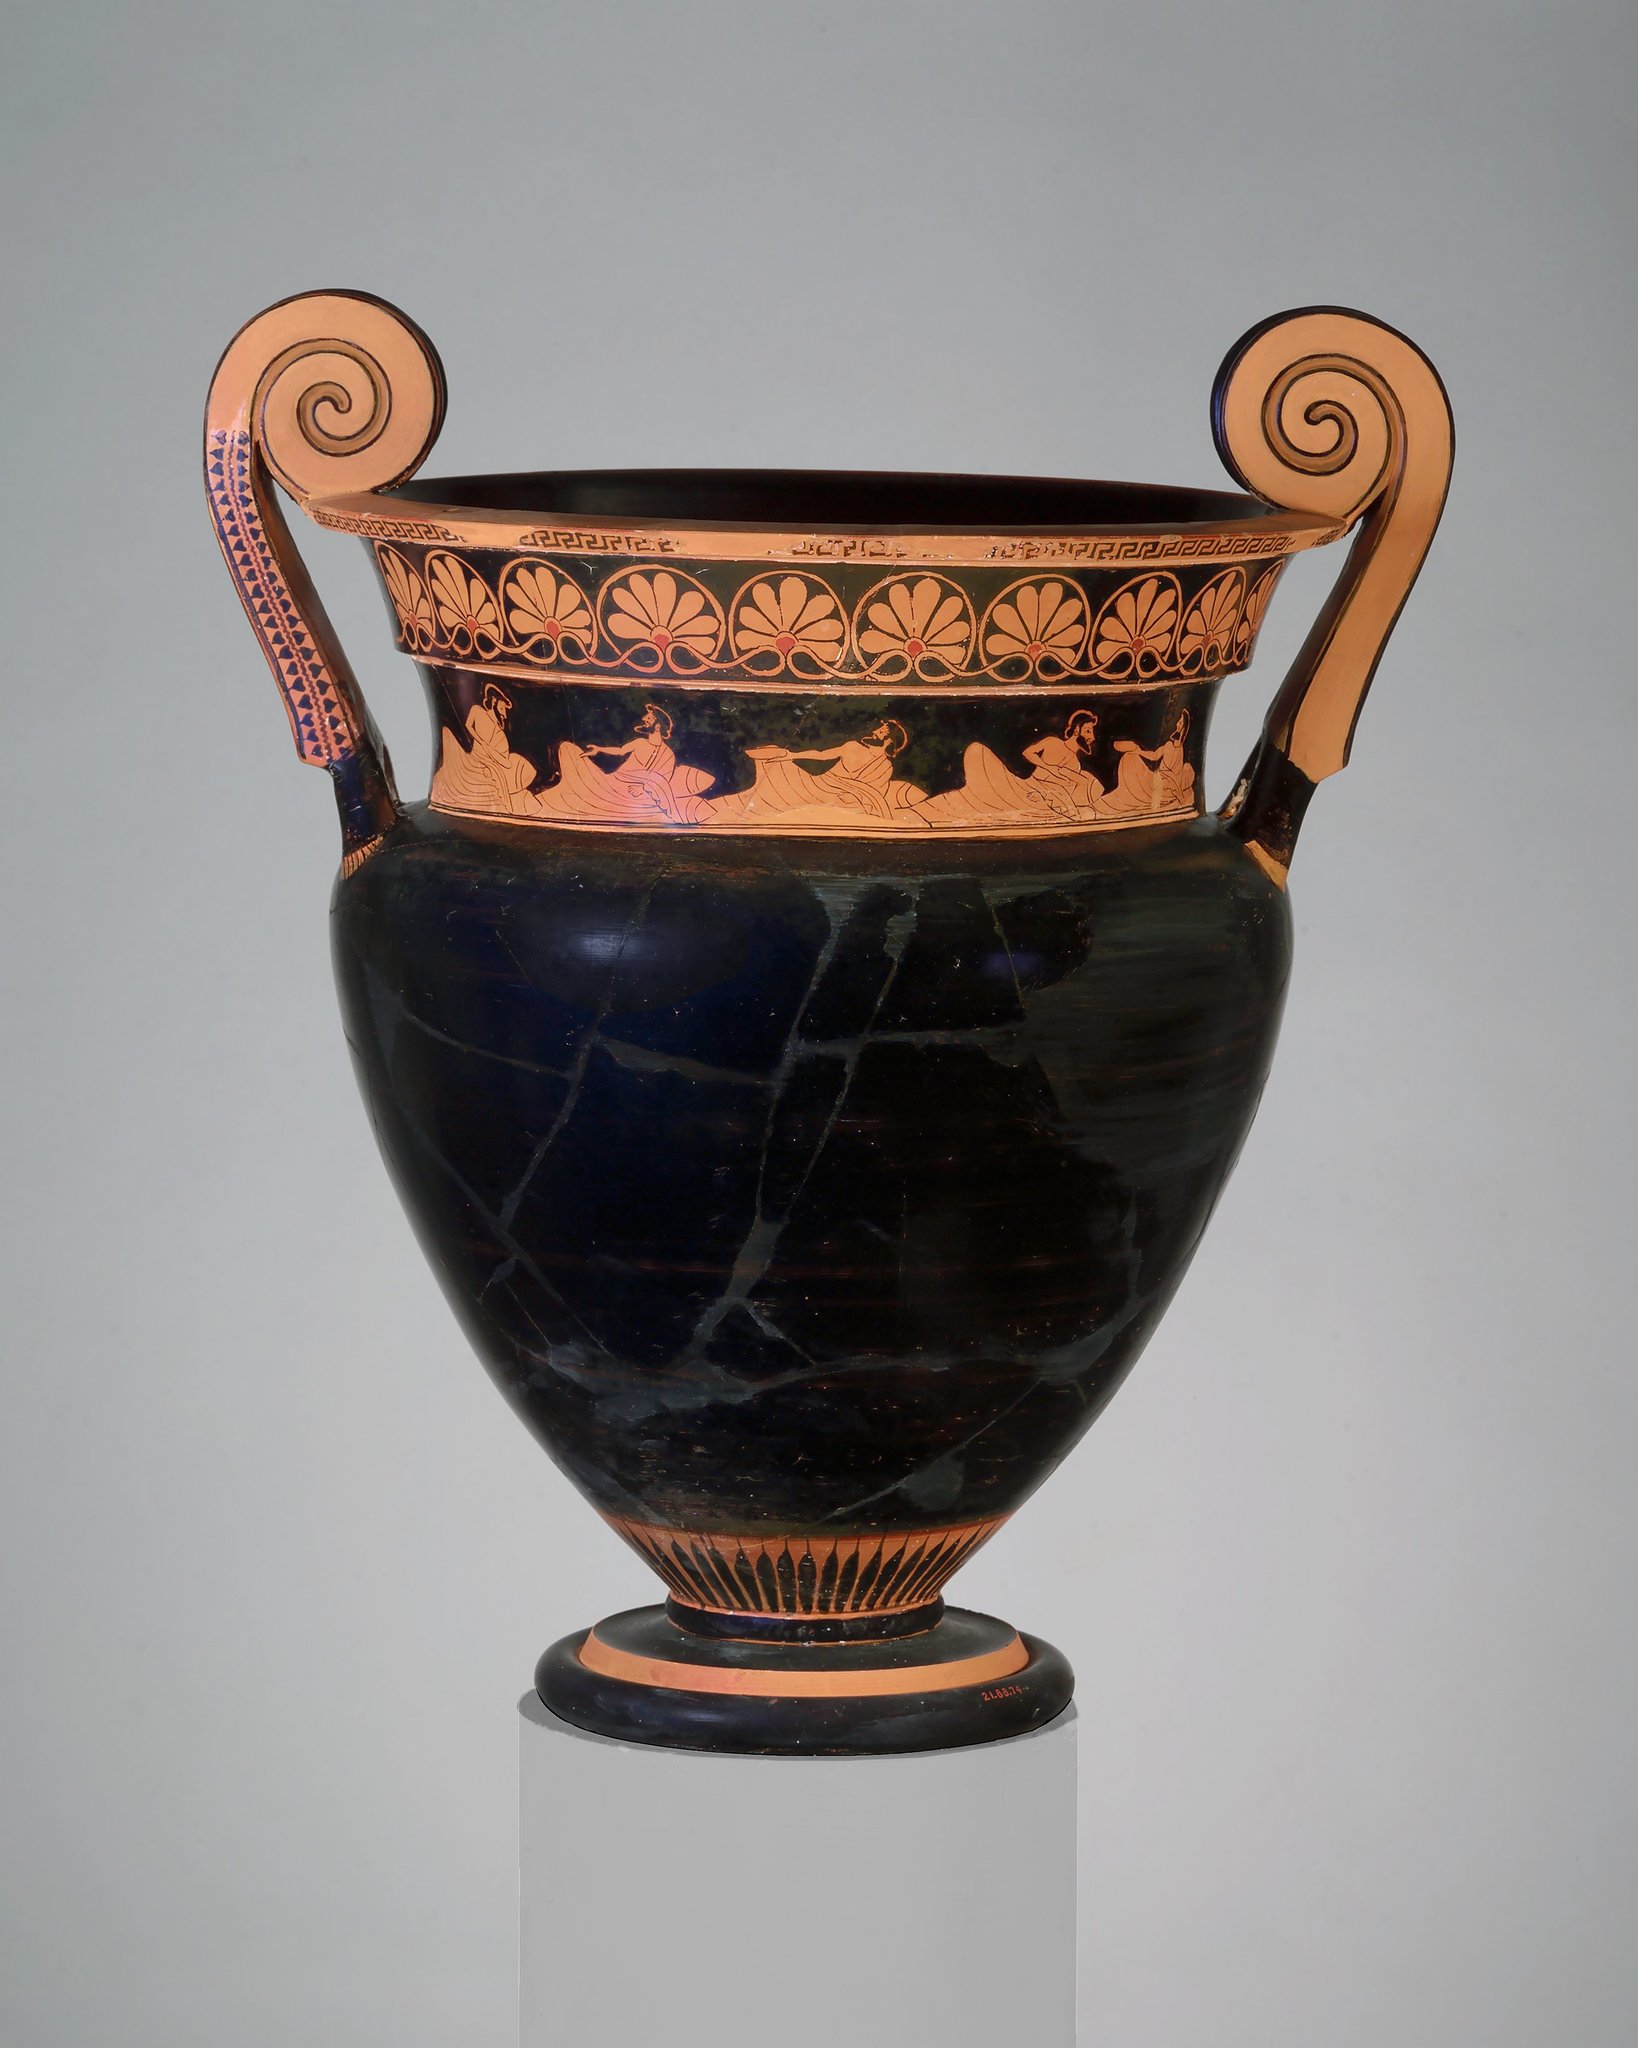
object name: volute krater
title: Terracotta volute-krater (bowl for mixing wine and water)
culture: greek, attic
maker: karkinos painter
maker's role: artist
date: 500 BCE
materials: terracotta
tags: men,amazons